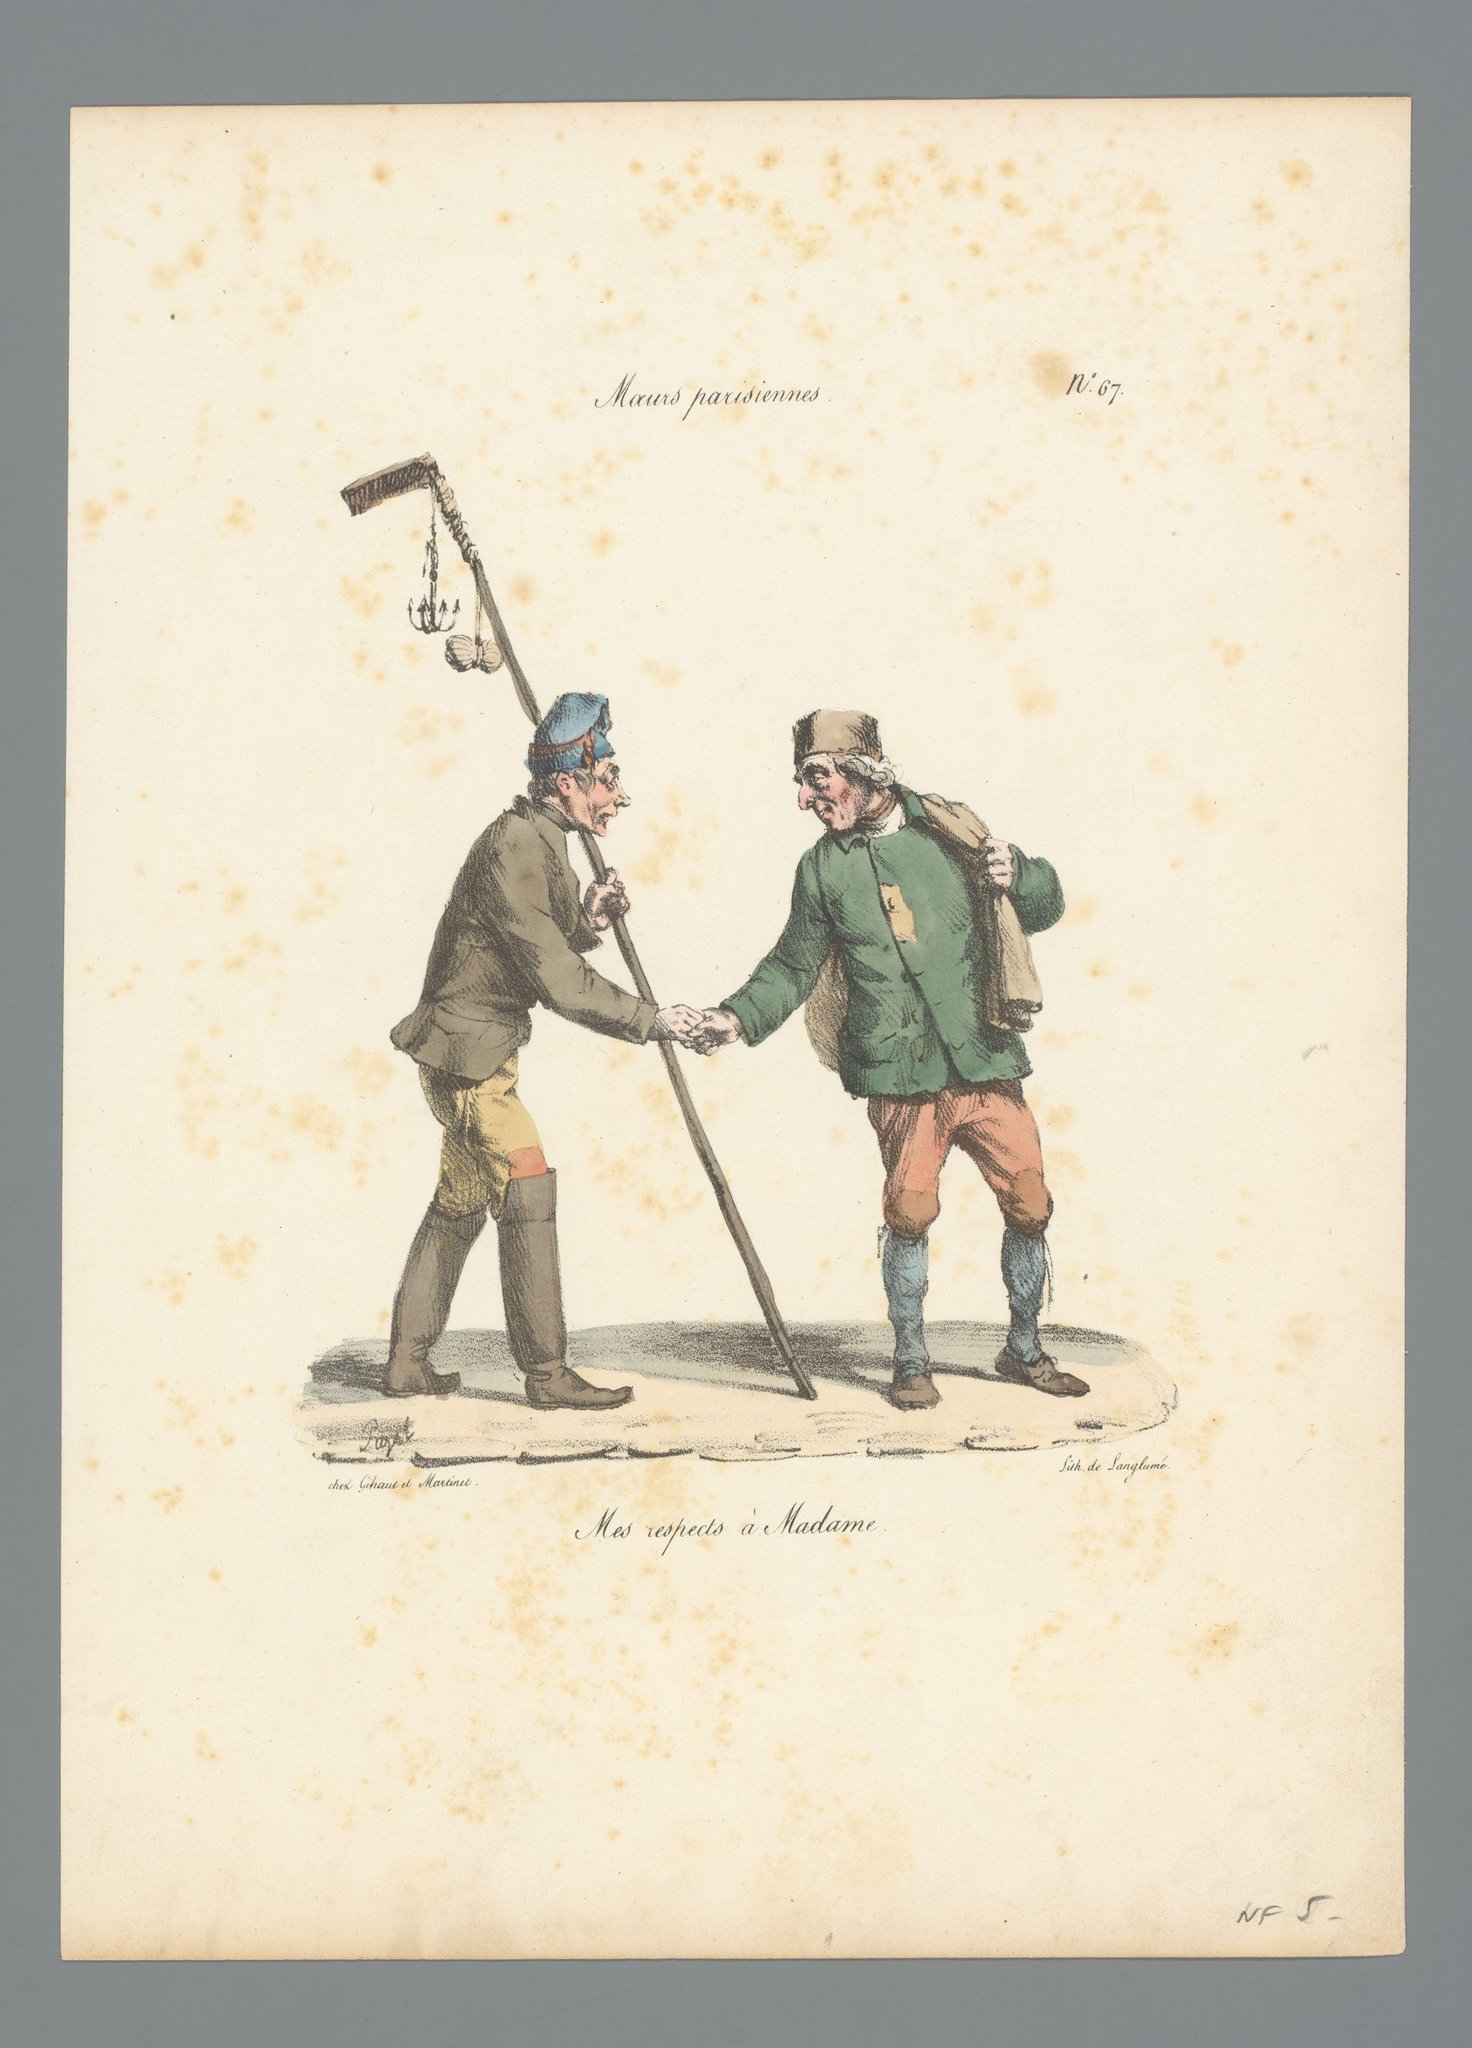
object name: print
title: Zeden en gewoonten van Parijs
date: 1825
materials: paper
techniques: hand coloring, lithograph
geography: paris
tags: adult man ( + one person)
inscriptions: collector's mark: Lugt 2228, inscription: ‘Paul Pronté, 74 Rue de Seine/ 30 Dec. 1964. NF 5.-’